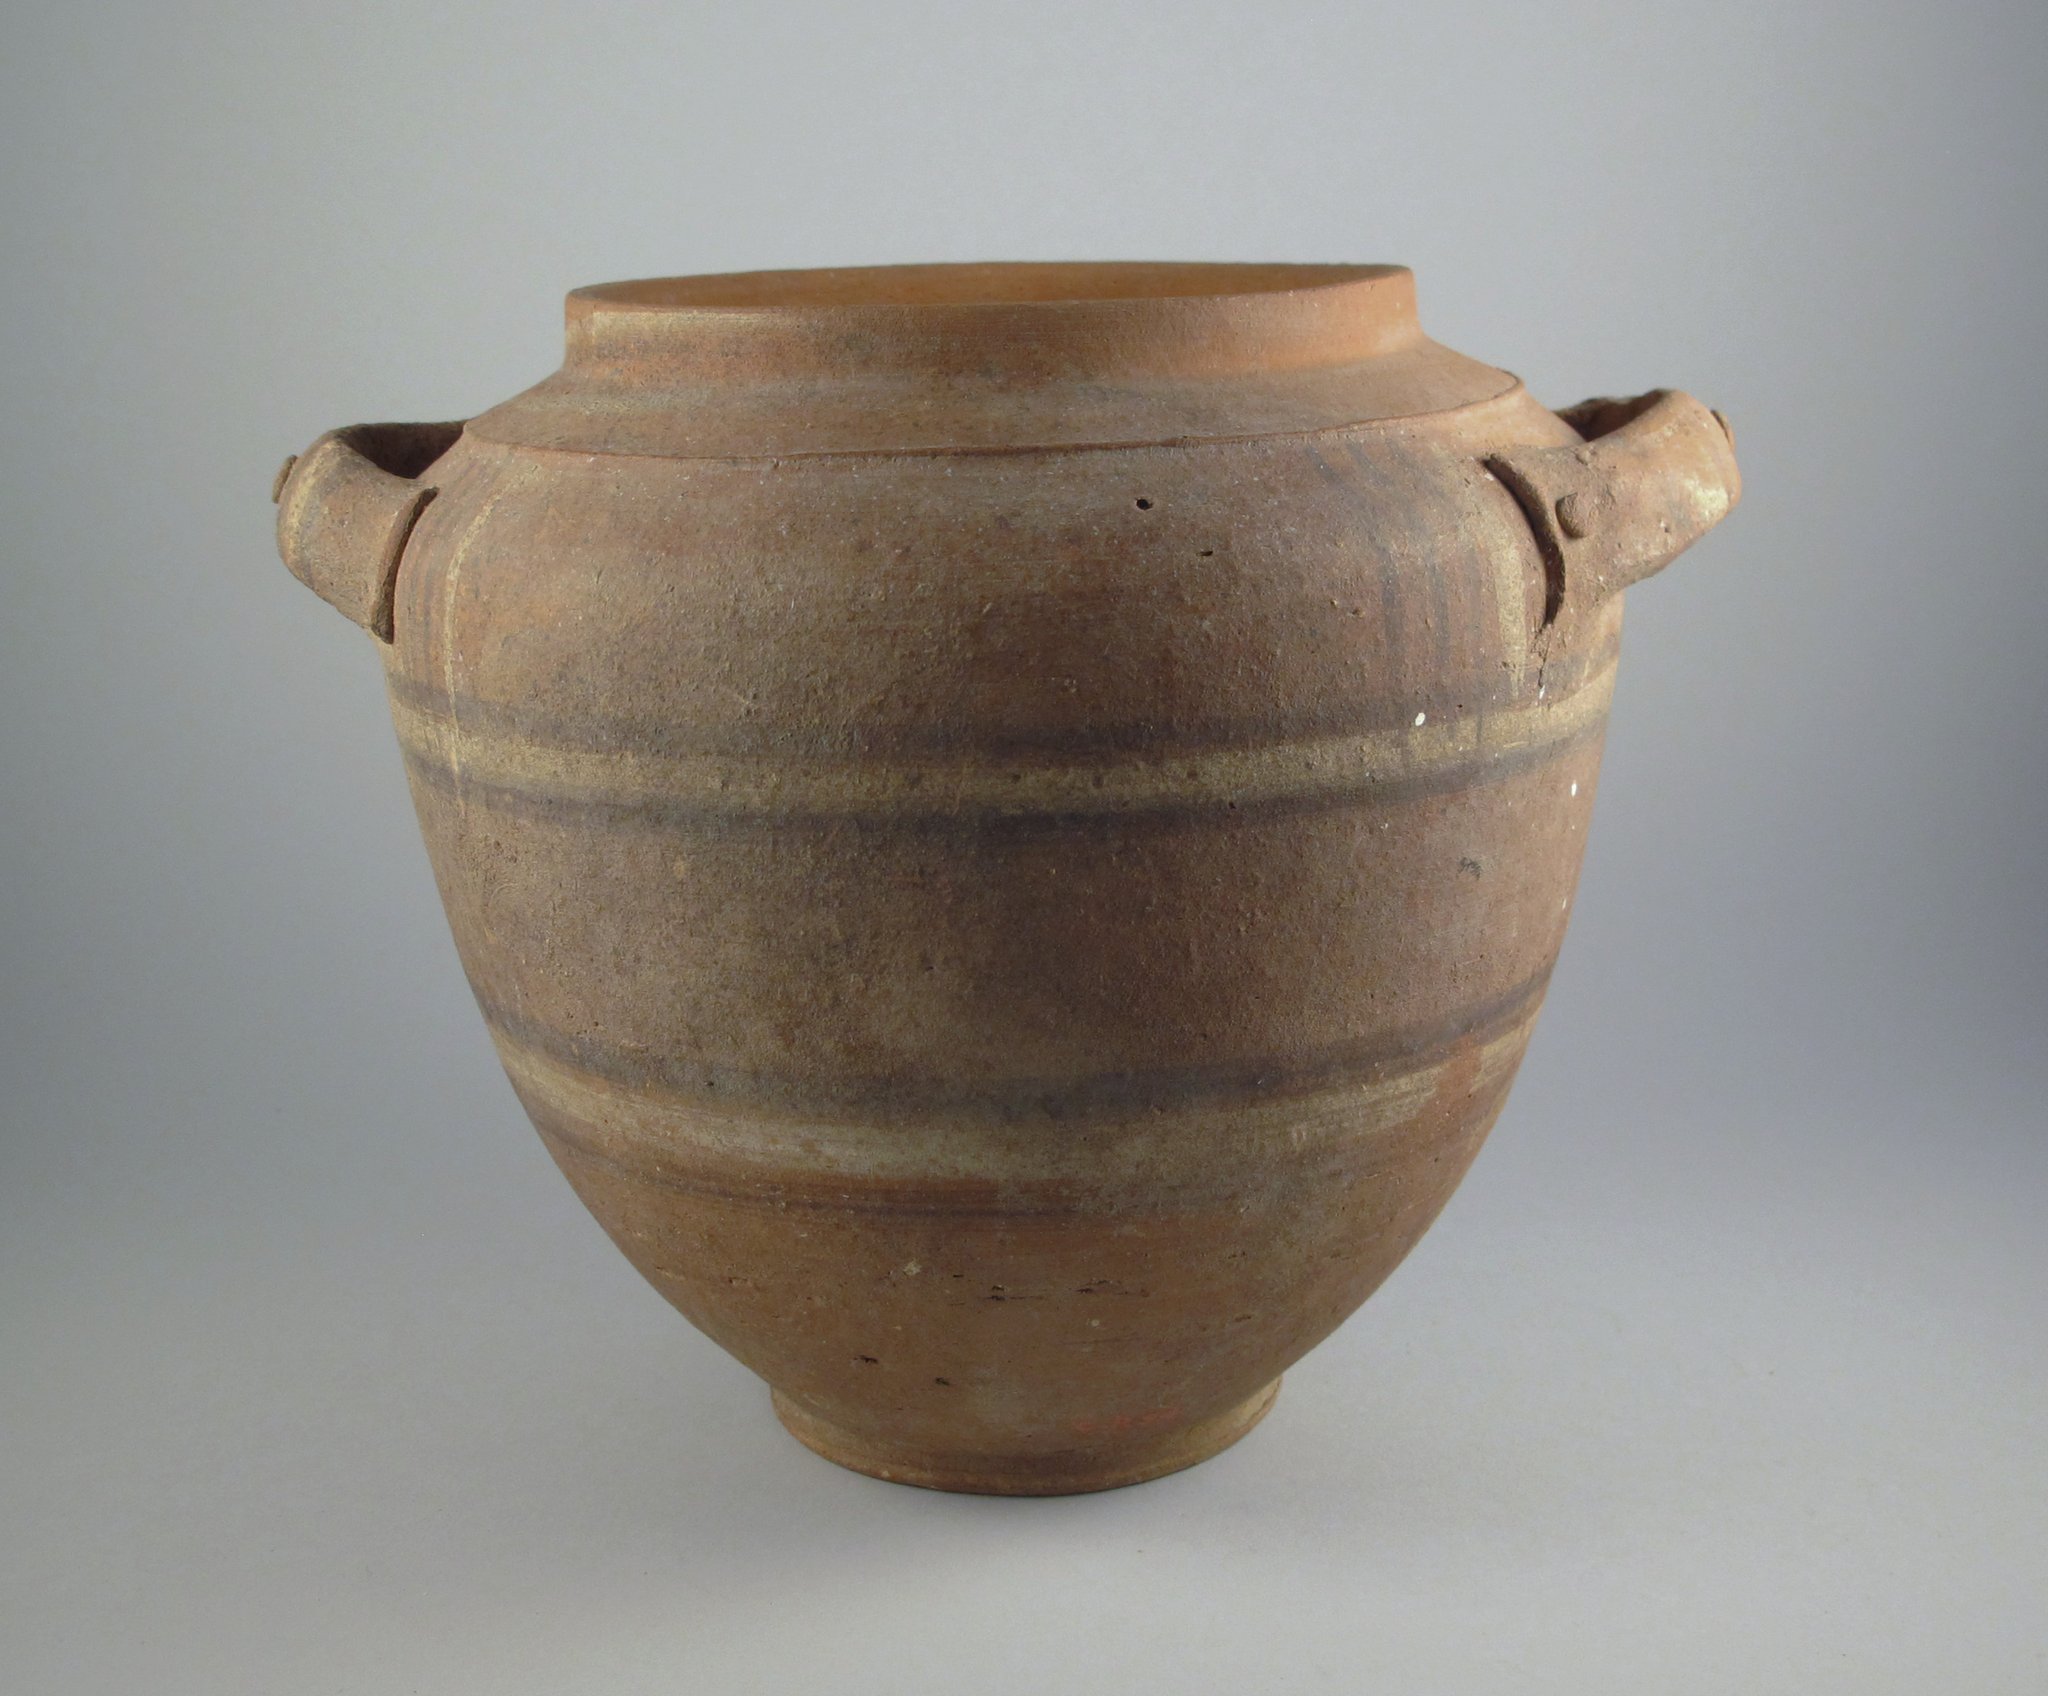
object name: krater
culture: cypriot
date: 750-600 BCE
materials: terracotta